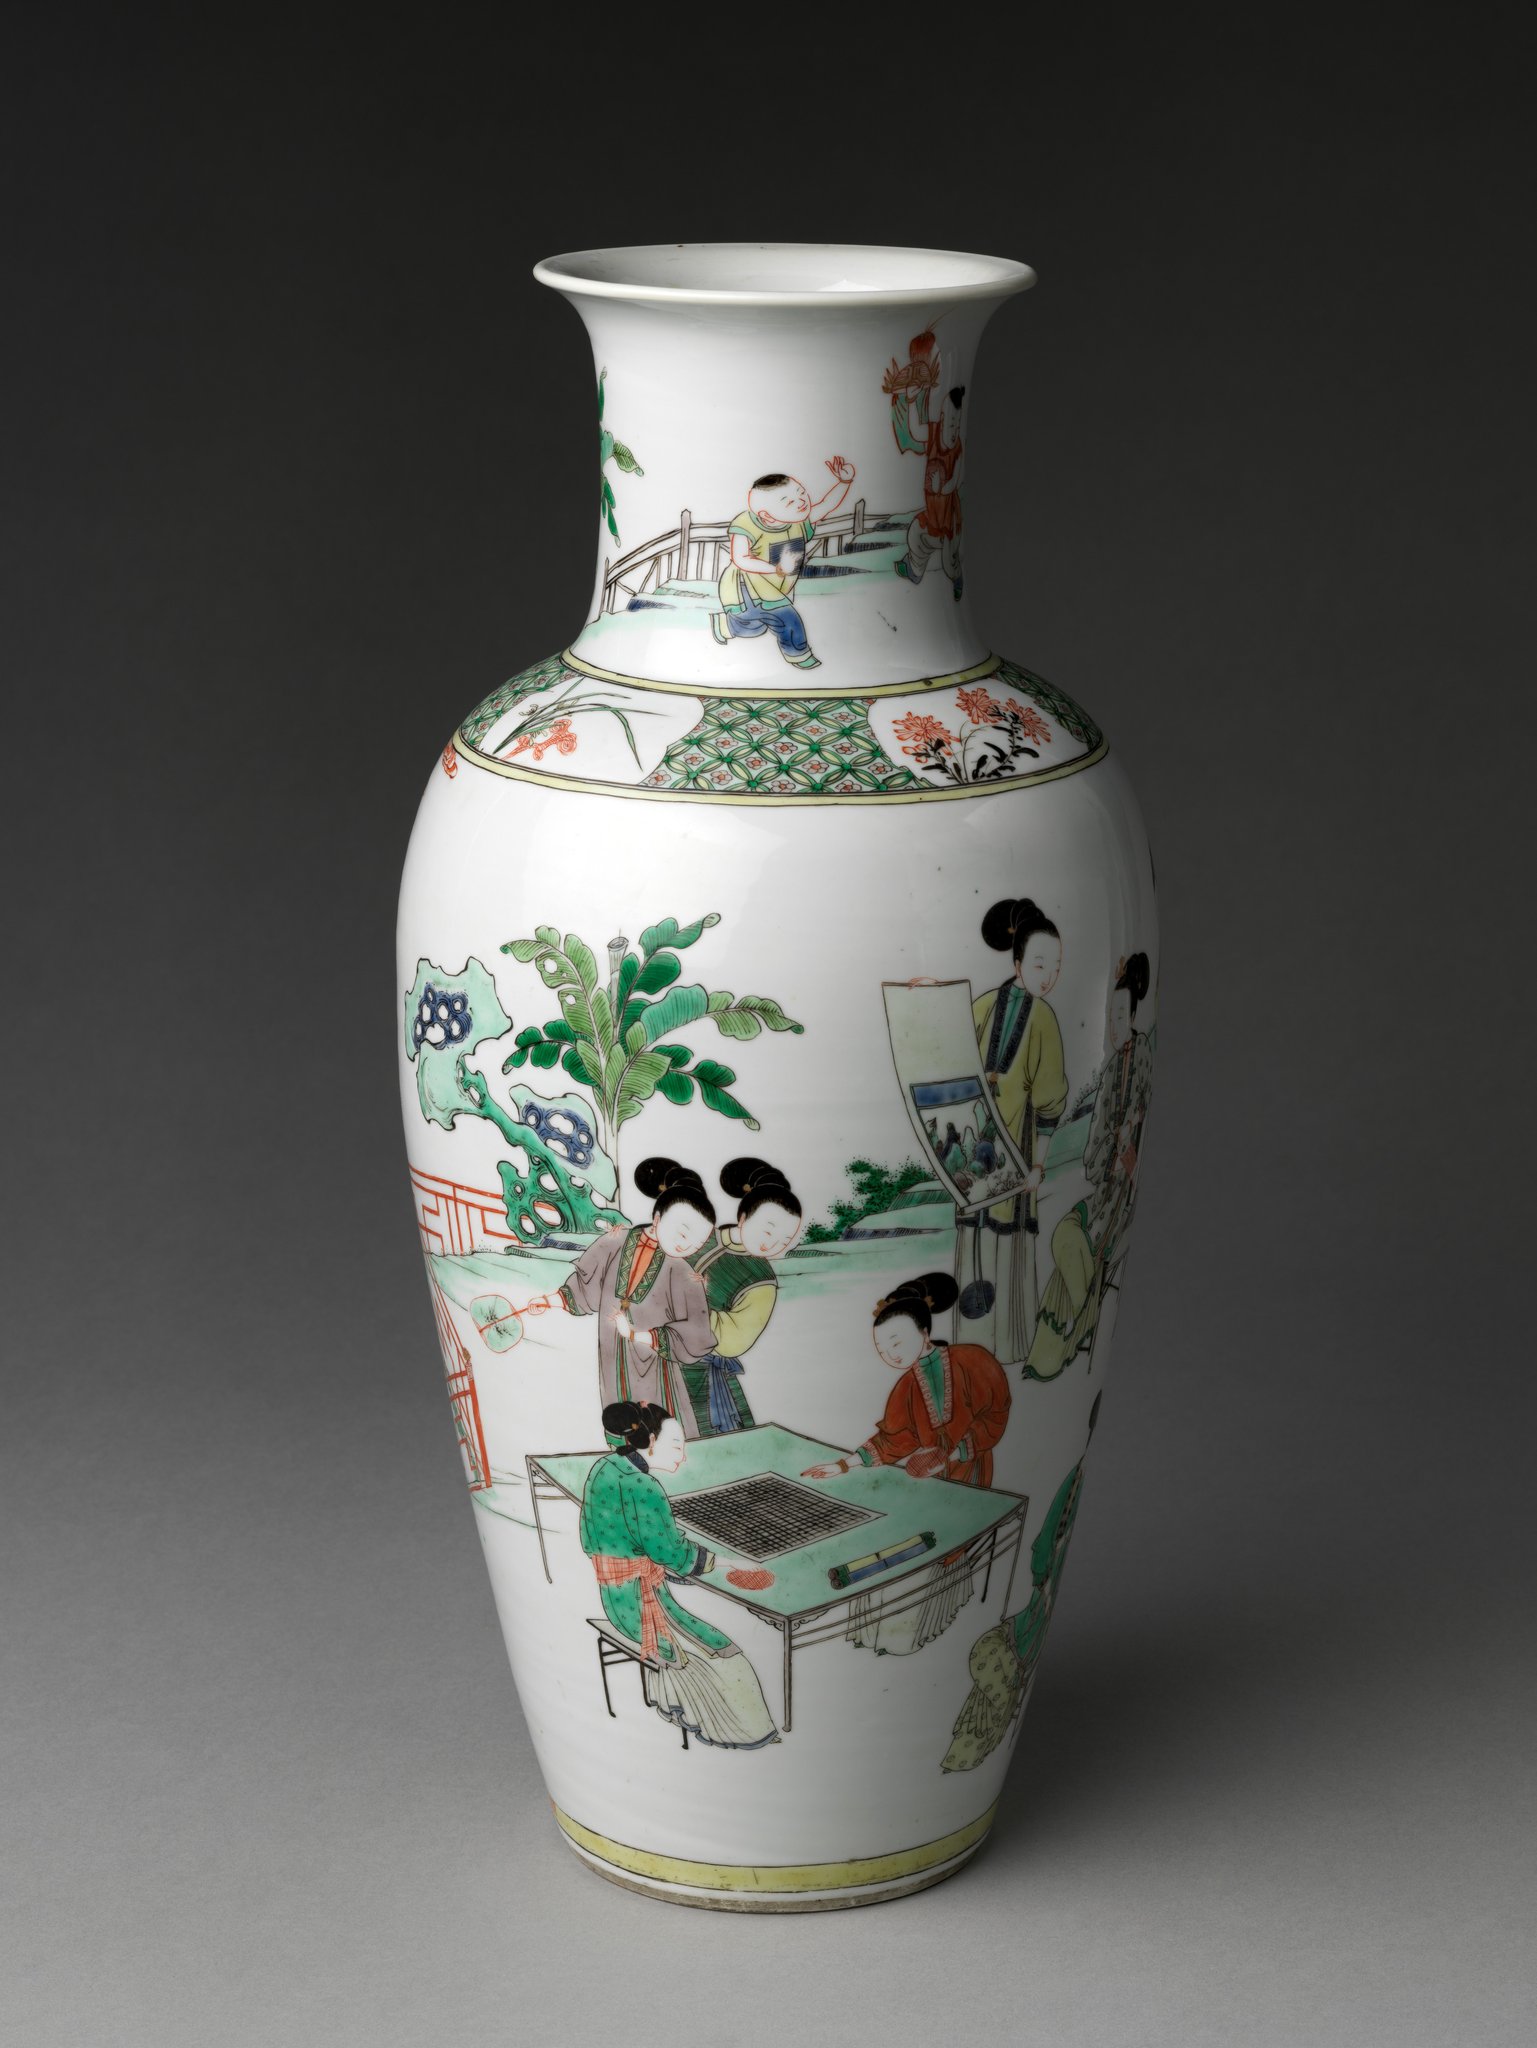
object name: vase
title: Vase with Women Enjoying Scholarly Pursuits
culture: chinese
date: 1667-1733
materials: enamel, glaze, porcelain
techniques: gilding, painting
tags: women,trees